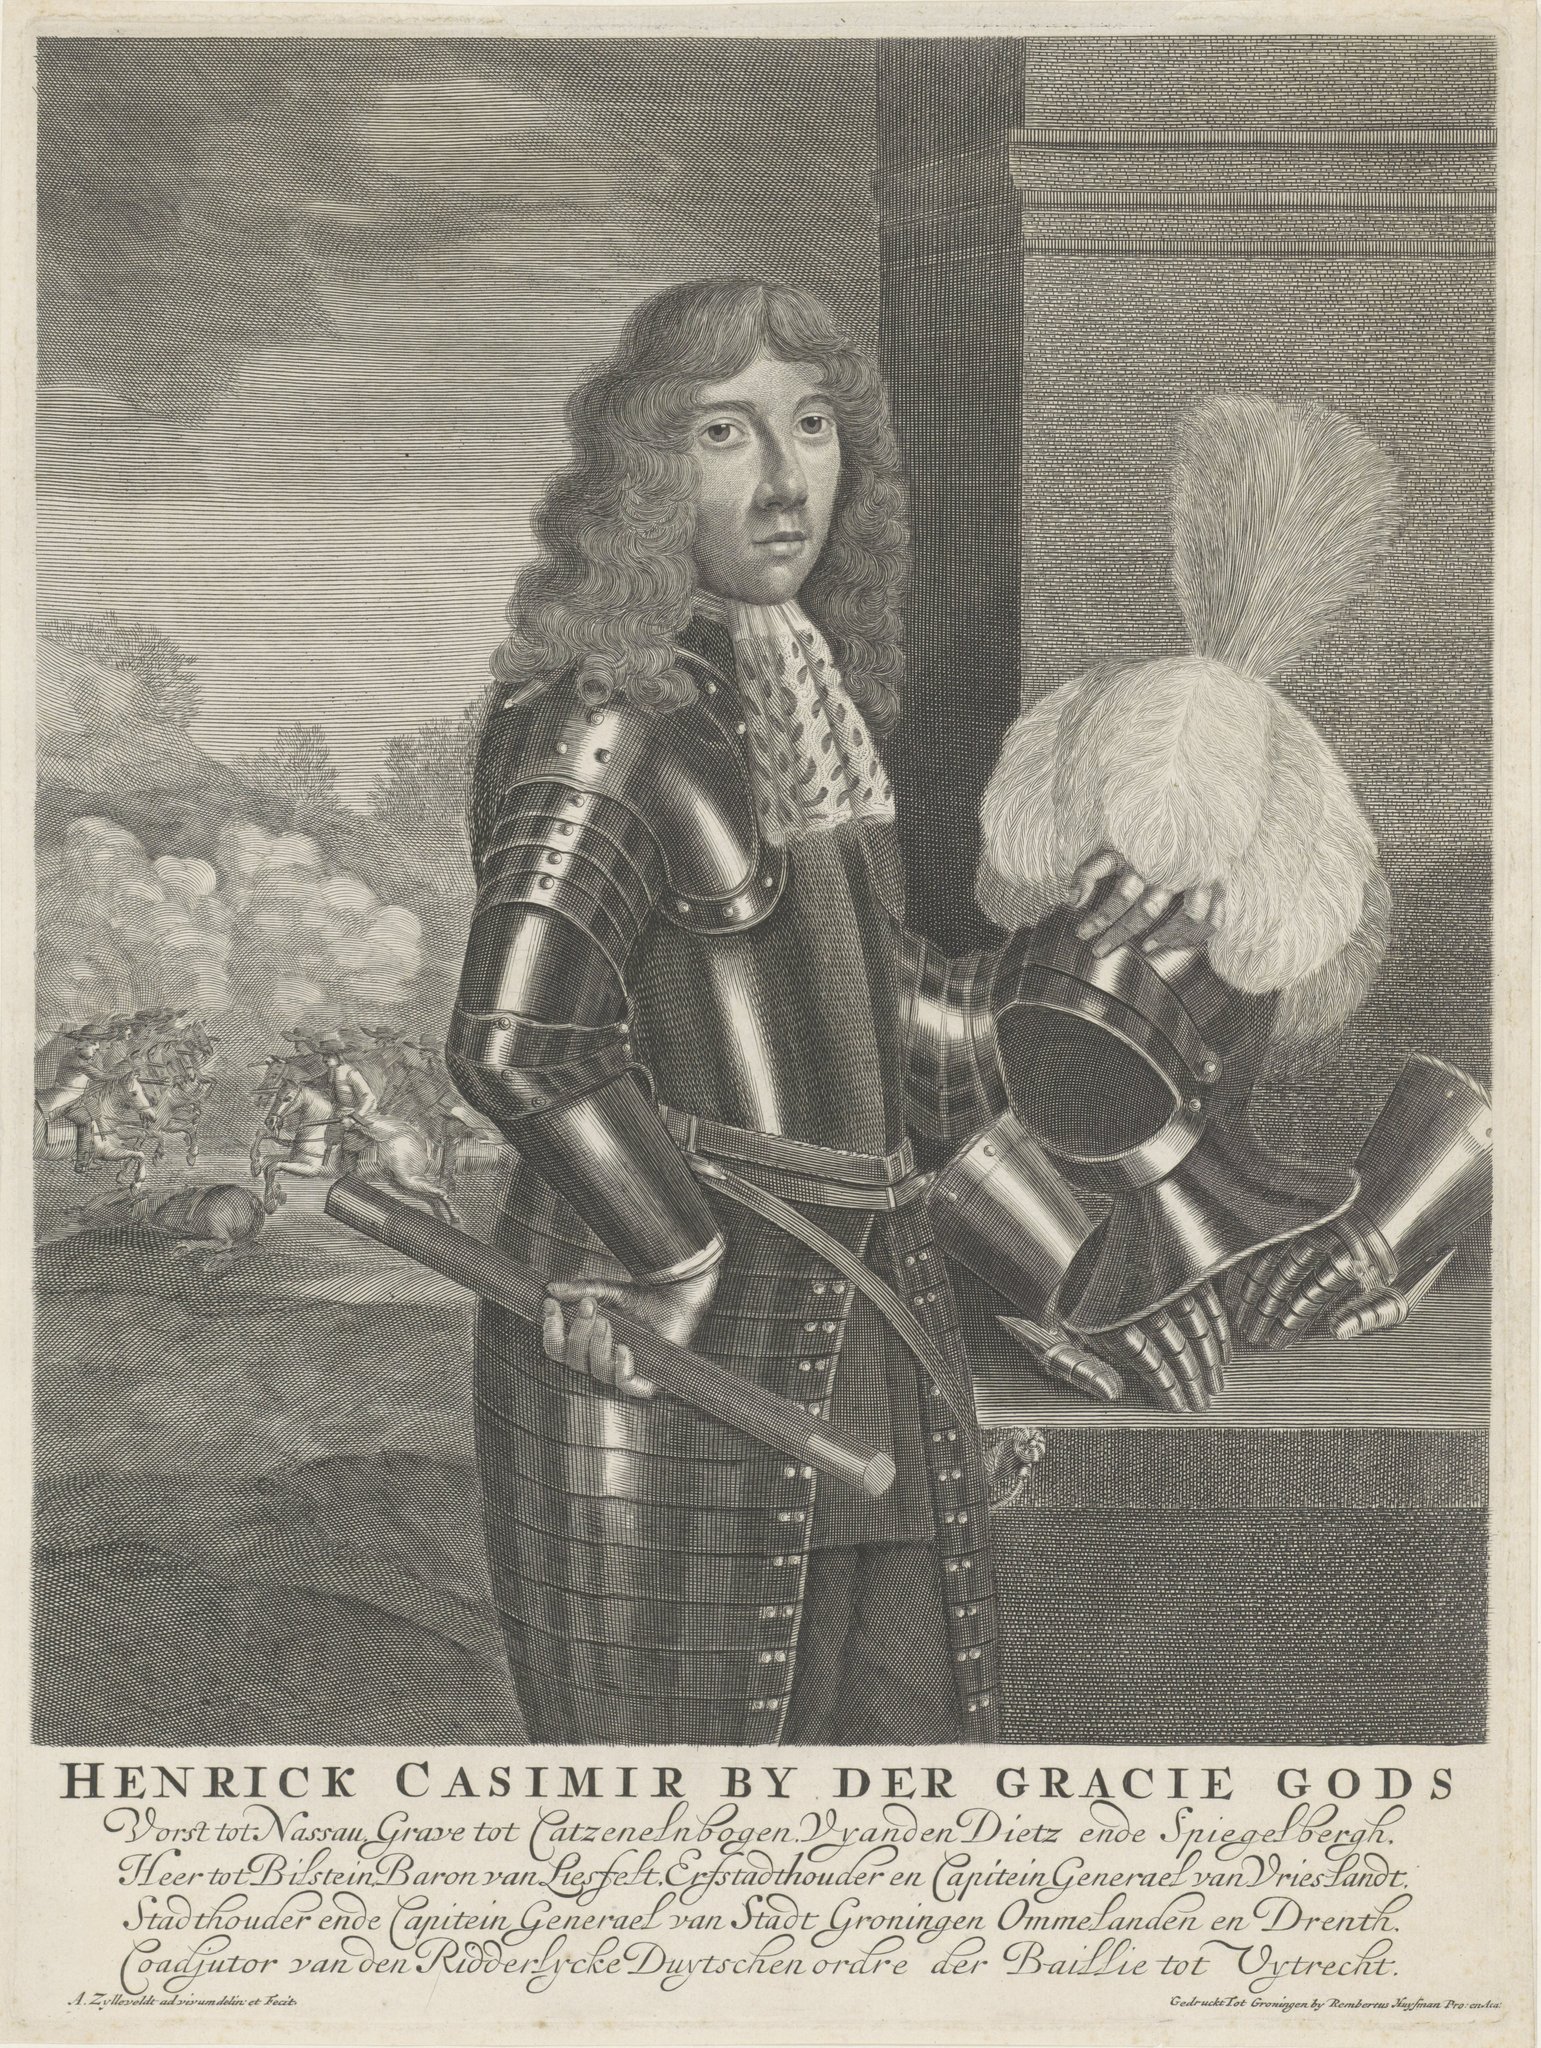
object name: print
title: Portret van Hendrik Casimir II, graaf van Nassau-Dietz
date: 1675-1681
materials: paper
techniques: engraving, etching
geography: northern netherlands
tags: hendrik casimir ii graaf van nassau-dietz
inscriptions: collector's mark: Lugt 2228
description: Portret van Hendrik Casimir II. In zijn rechterhand een commandostaf en in zijn linkerhand zijn helm. Op de achtergrond een ruitergevecht. In de ondermarge vijf regels Nederlandse tekst.